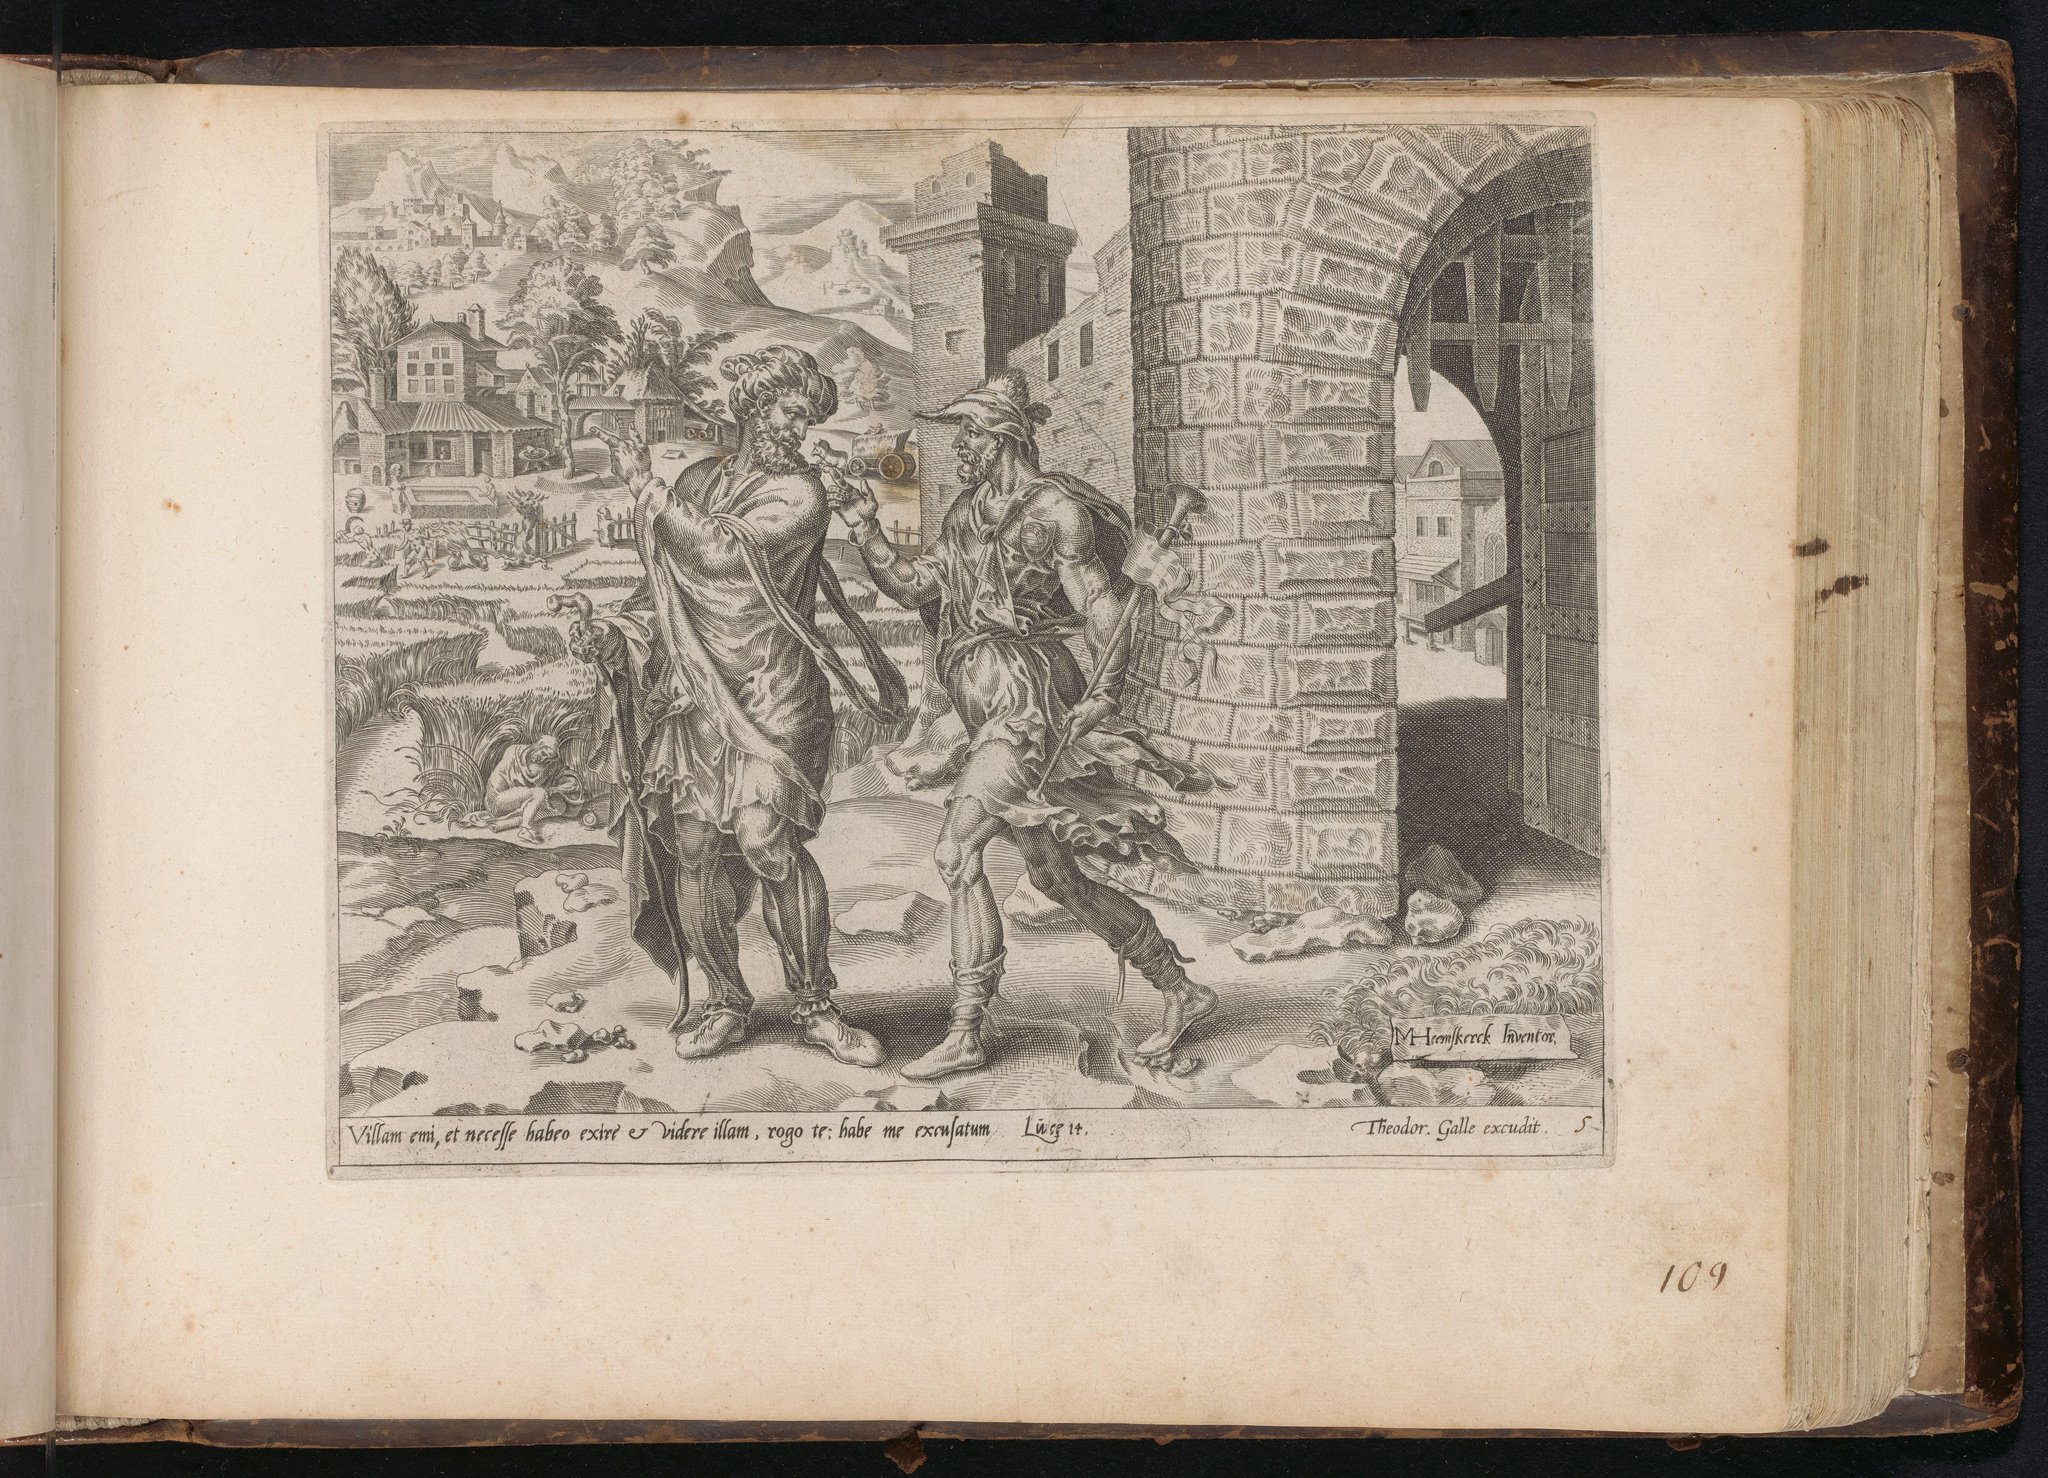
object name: album leaf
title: Van d'Inrydingh Iesu, en eenige geschiedenissen daer op gevolcht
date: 1558-1559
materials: paper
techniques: engraving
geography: amsterdam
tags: those that are invited to the royal wedding-feast excuse themselves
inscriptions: number: ‘109’, serial number: ‘5’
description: Een dienaar van de koning komt bij de eerste gast en nodigt hem uit voor het bruiloftsfeest. De gast verontschuldigt zich met het excuus dat hij net een nieuwe akker heeft gekocht, die hij eerst moet gaan bekijken. Onder de voorstelling een verwijzing in het Latijn naar de Bijbeltekst in Luc. 14. Deze prent maakt deel uit van een album.